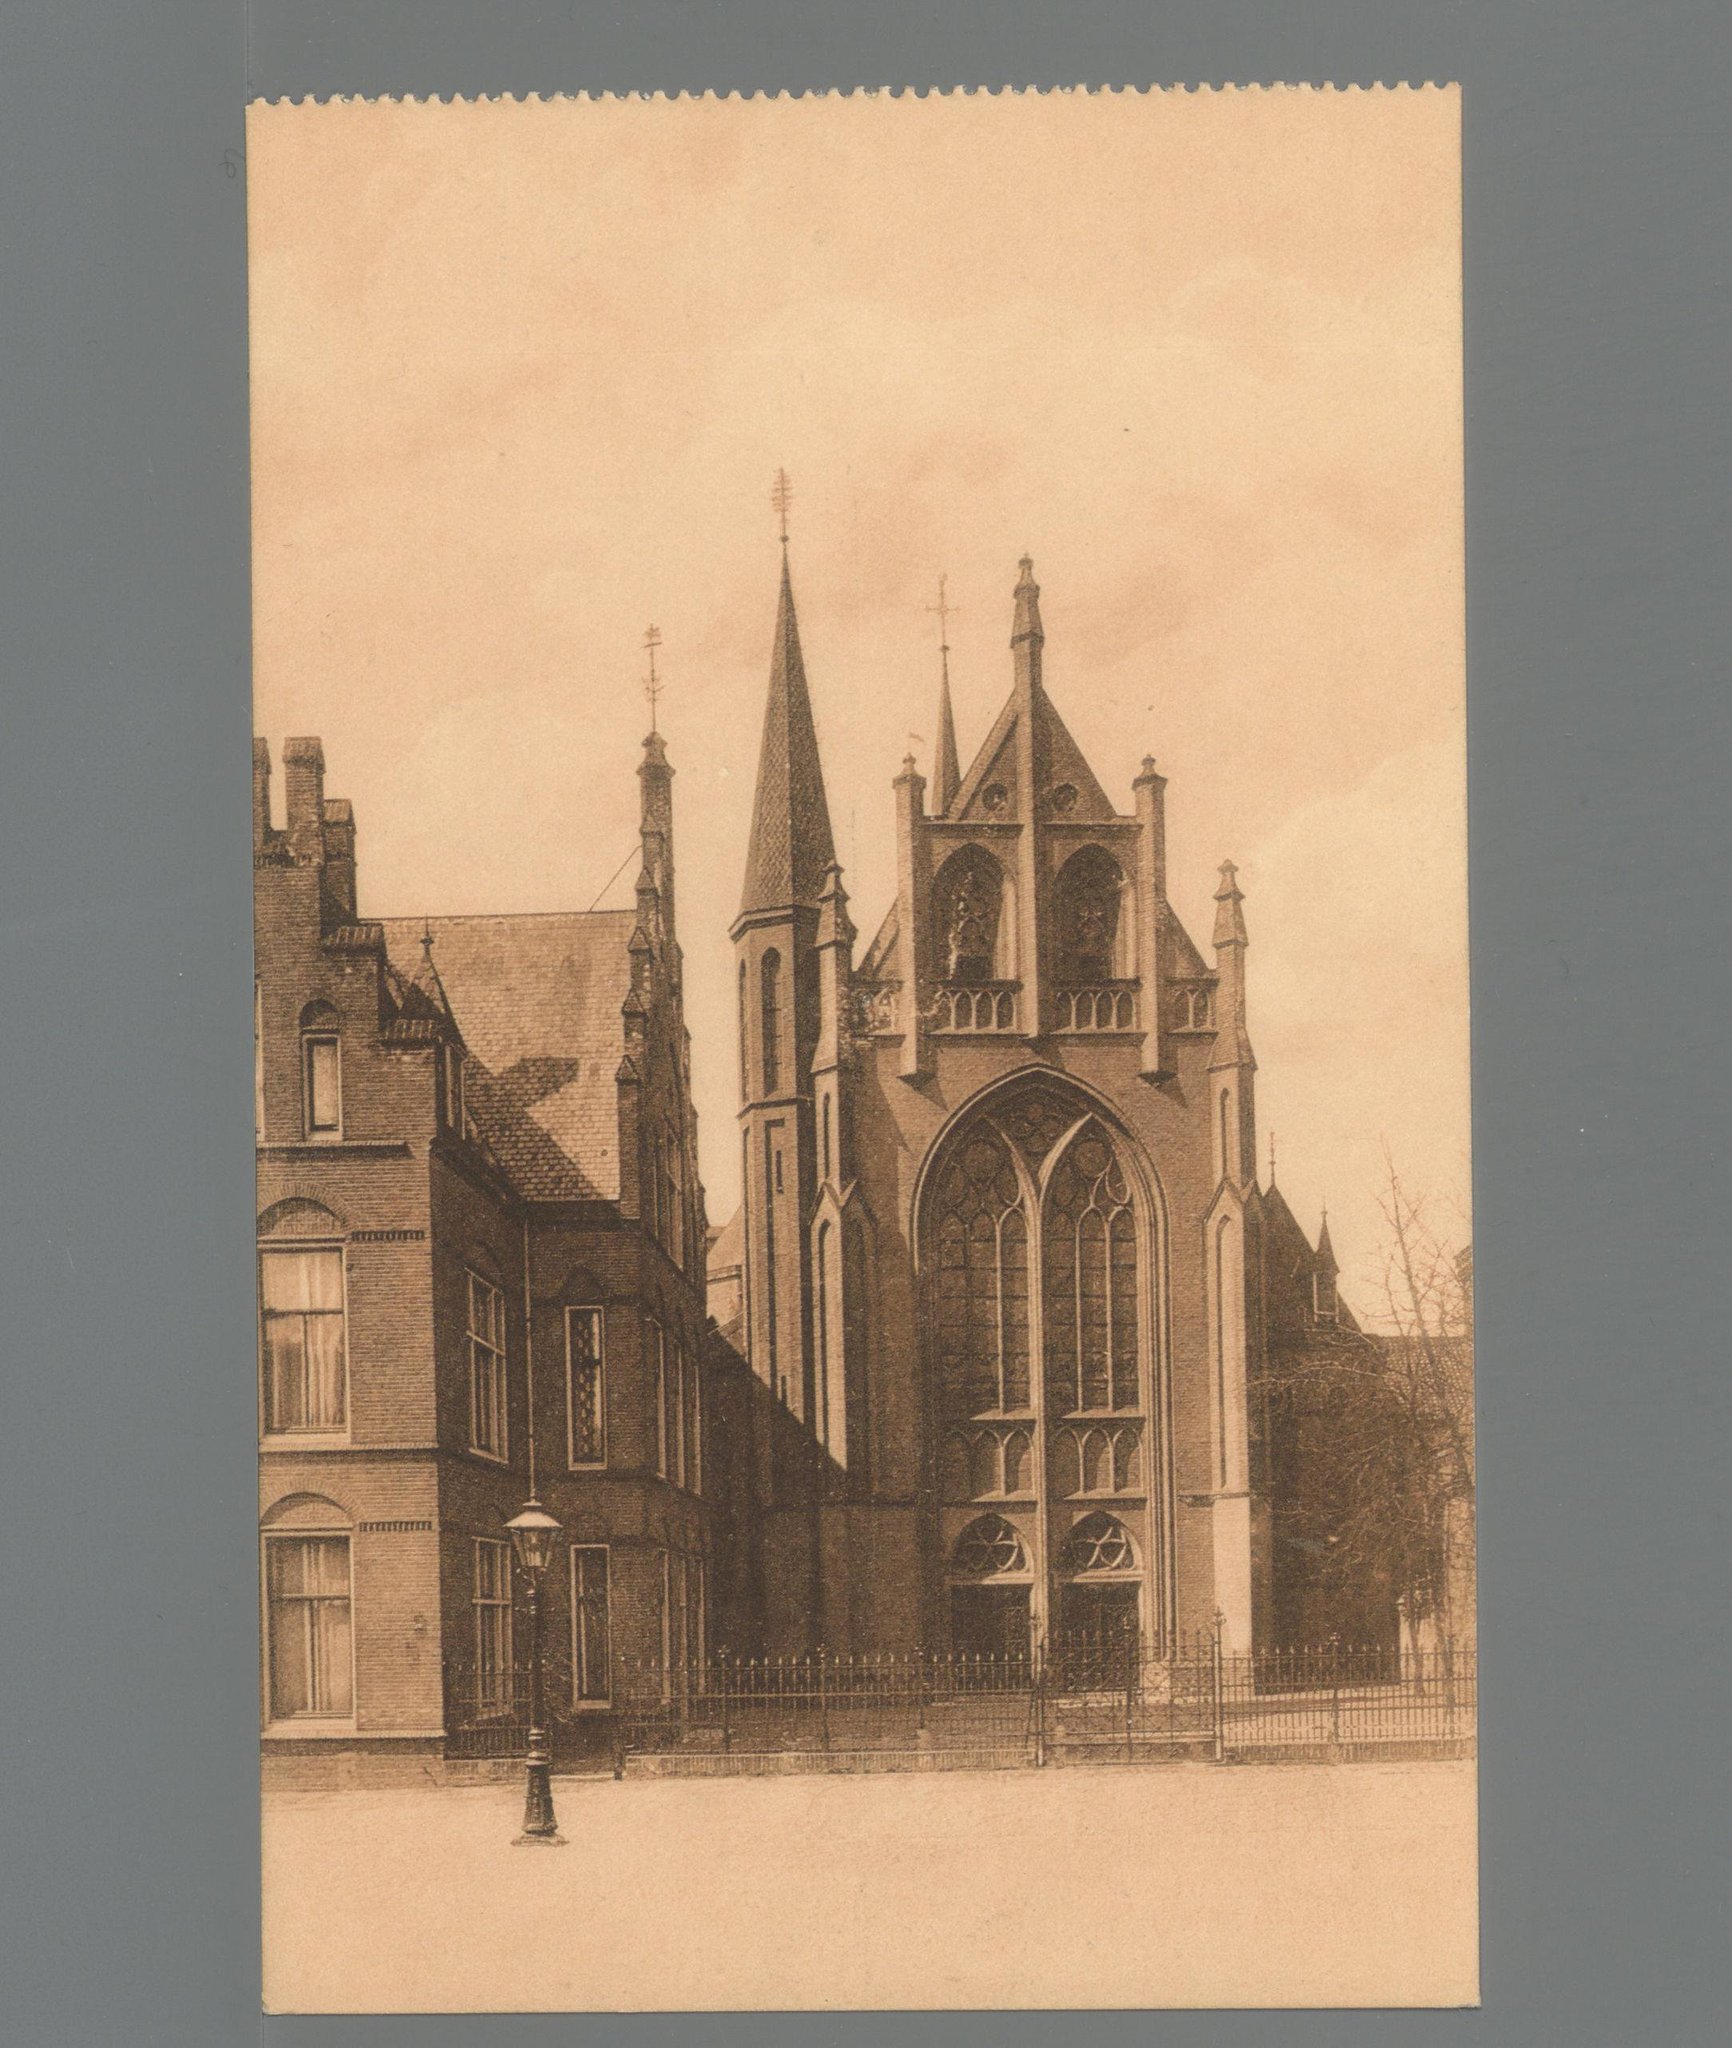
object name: ansichtkaart, prentbriefkaart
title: Parochiekerk St. Martinus. Utrecht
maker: Anonymous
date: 1905-1930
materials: cardboard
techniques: photograph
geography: utrecht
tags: church (exterior)